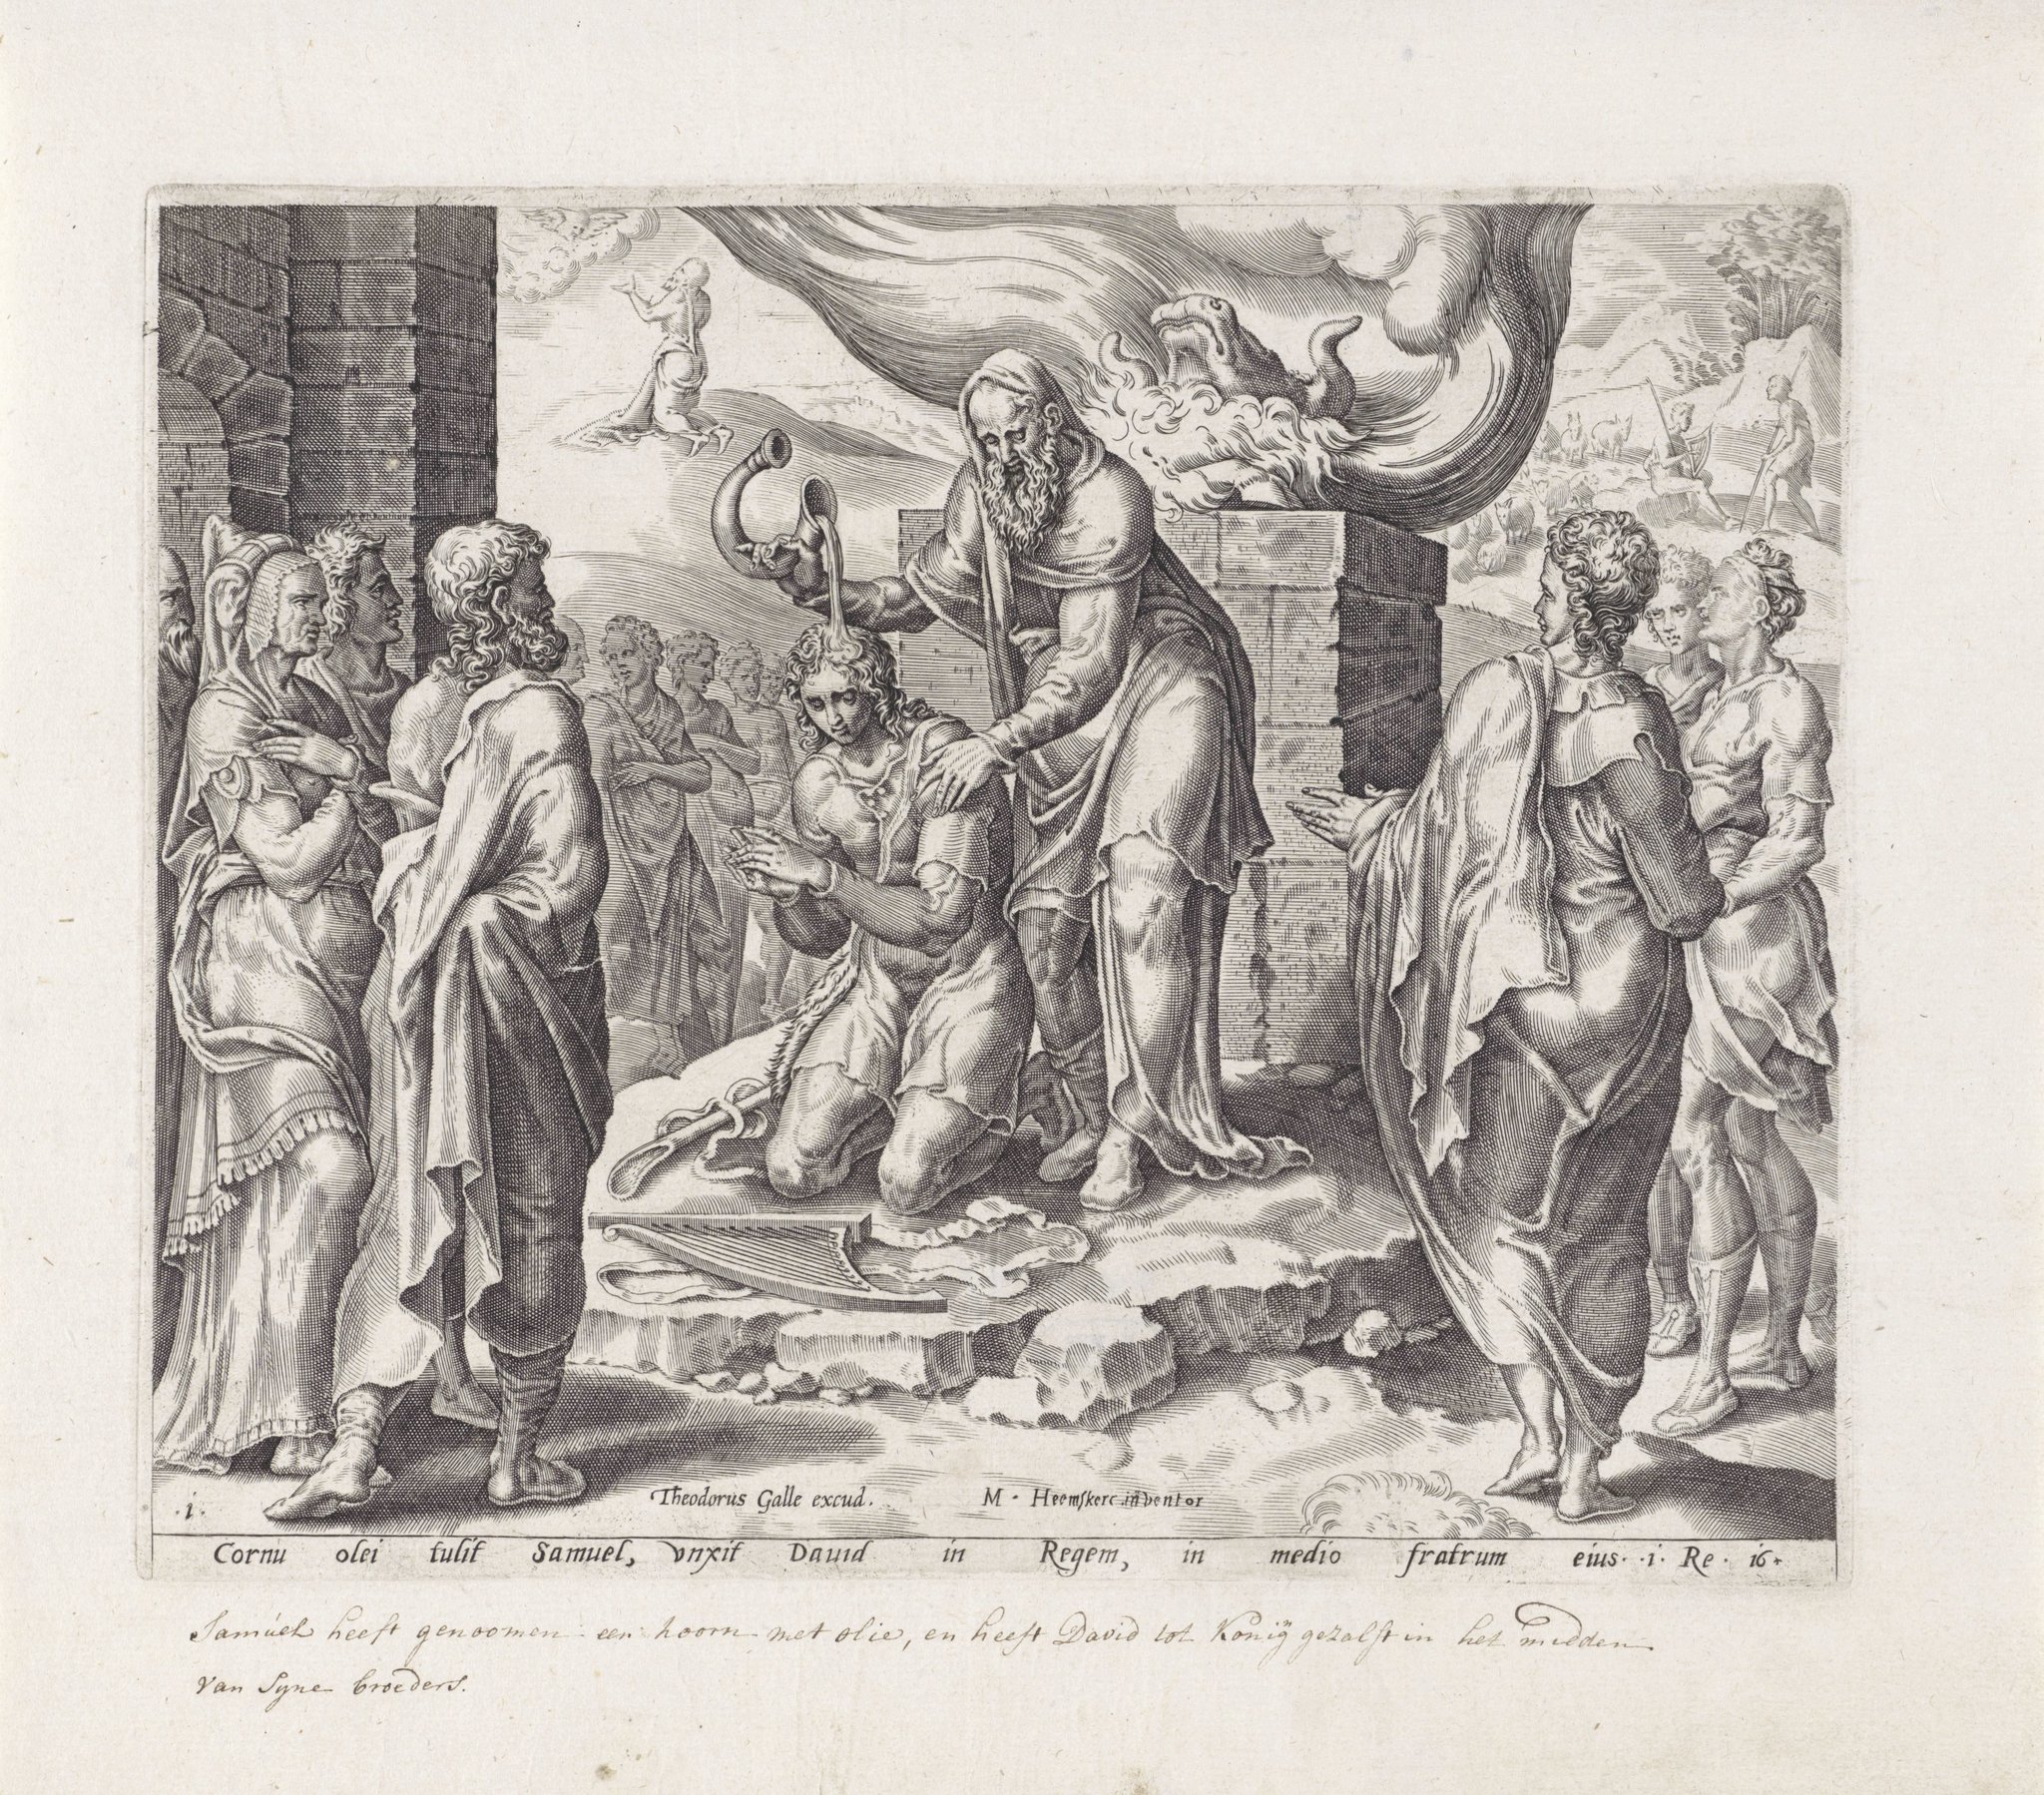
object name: print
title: Verhaal van David en Saul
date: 1595-1633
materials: paper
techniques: engraving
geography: antwerp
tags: samuel anointing david in the presence of his father jesse and his brothers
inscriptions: collector's mark: Lugt 2228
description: David knielt voor de profeet Samuel, die hem met olie uit een hoorn tot koning zalft. Voor David ligt zijn harp. Onder andere zijn vader Isaï en Davids broers kijken toe. Achter Samuel wordt de kop van een koe geofferd. Linksachter vraagt Samuel God om raad en rechtsachter wordt David opgehaald om voor Samuel te verschijnen. In de marge een éénregelig onderschrift in het Latijn uit 1 Sam. (foutief aangeduid als 1 Koningen op de prent).